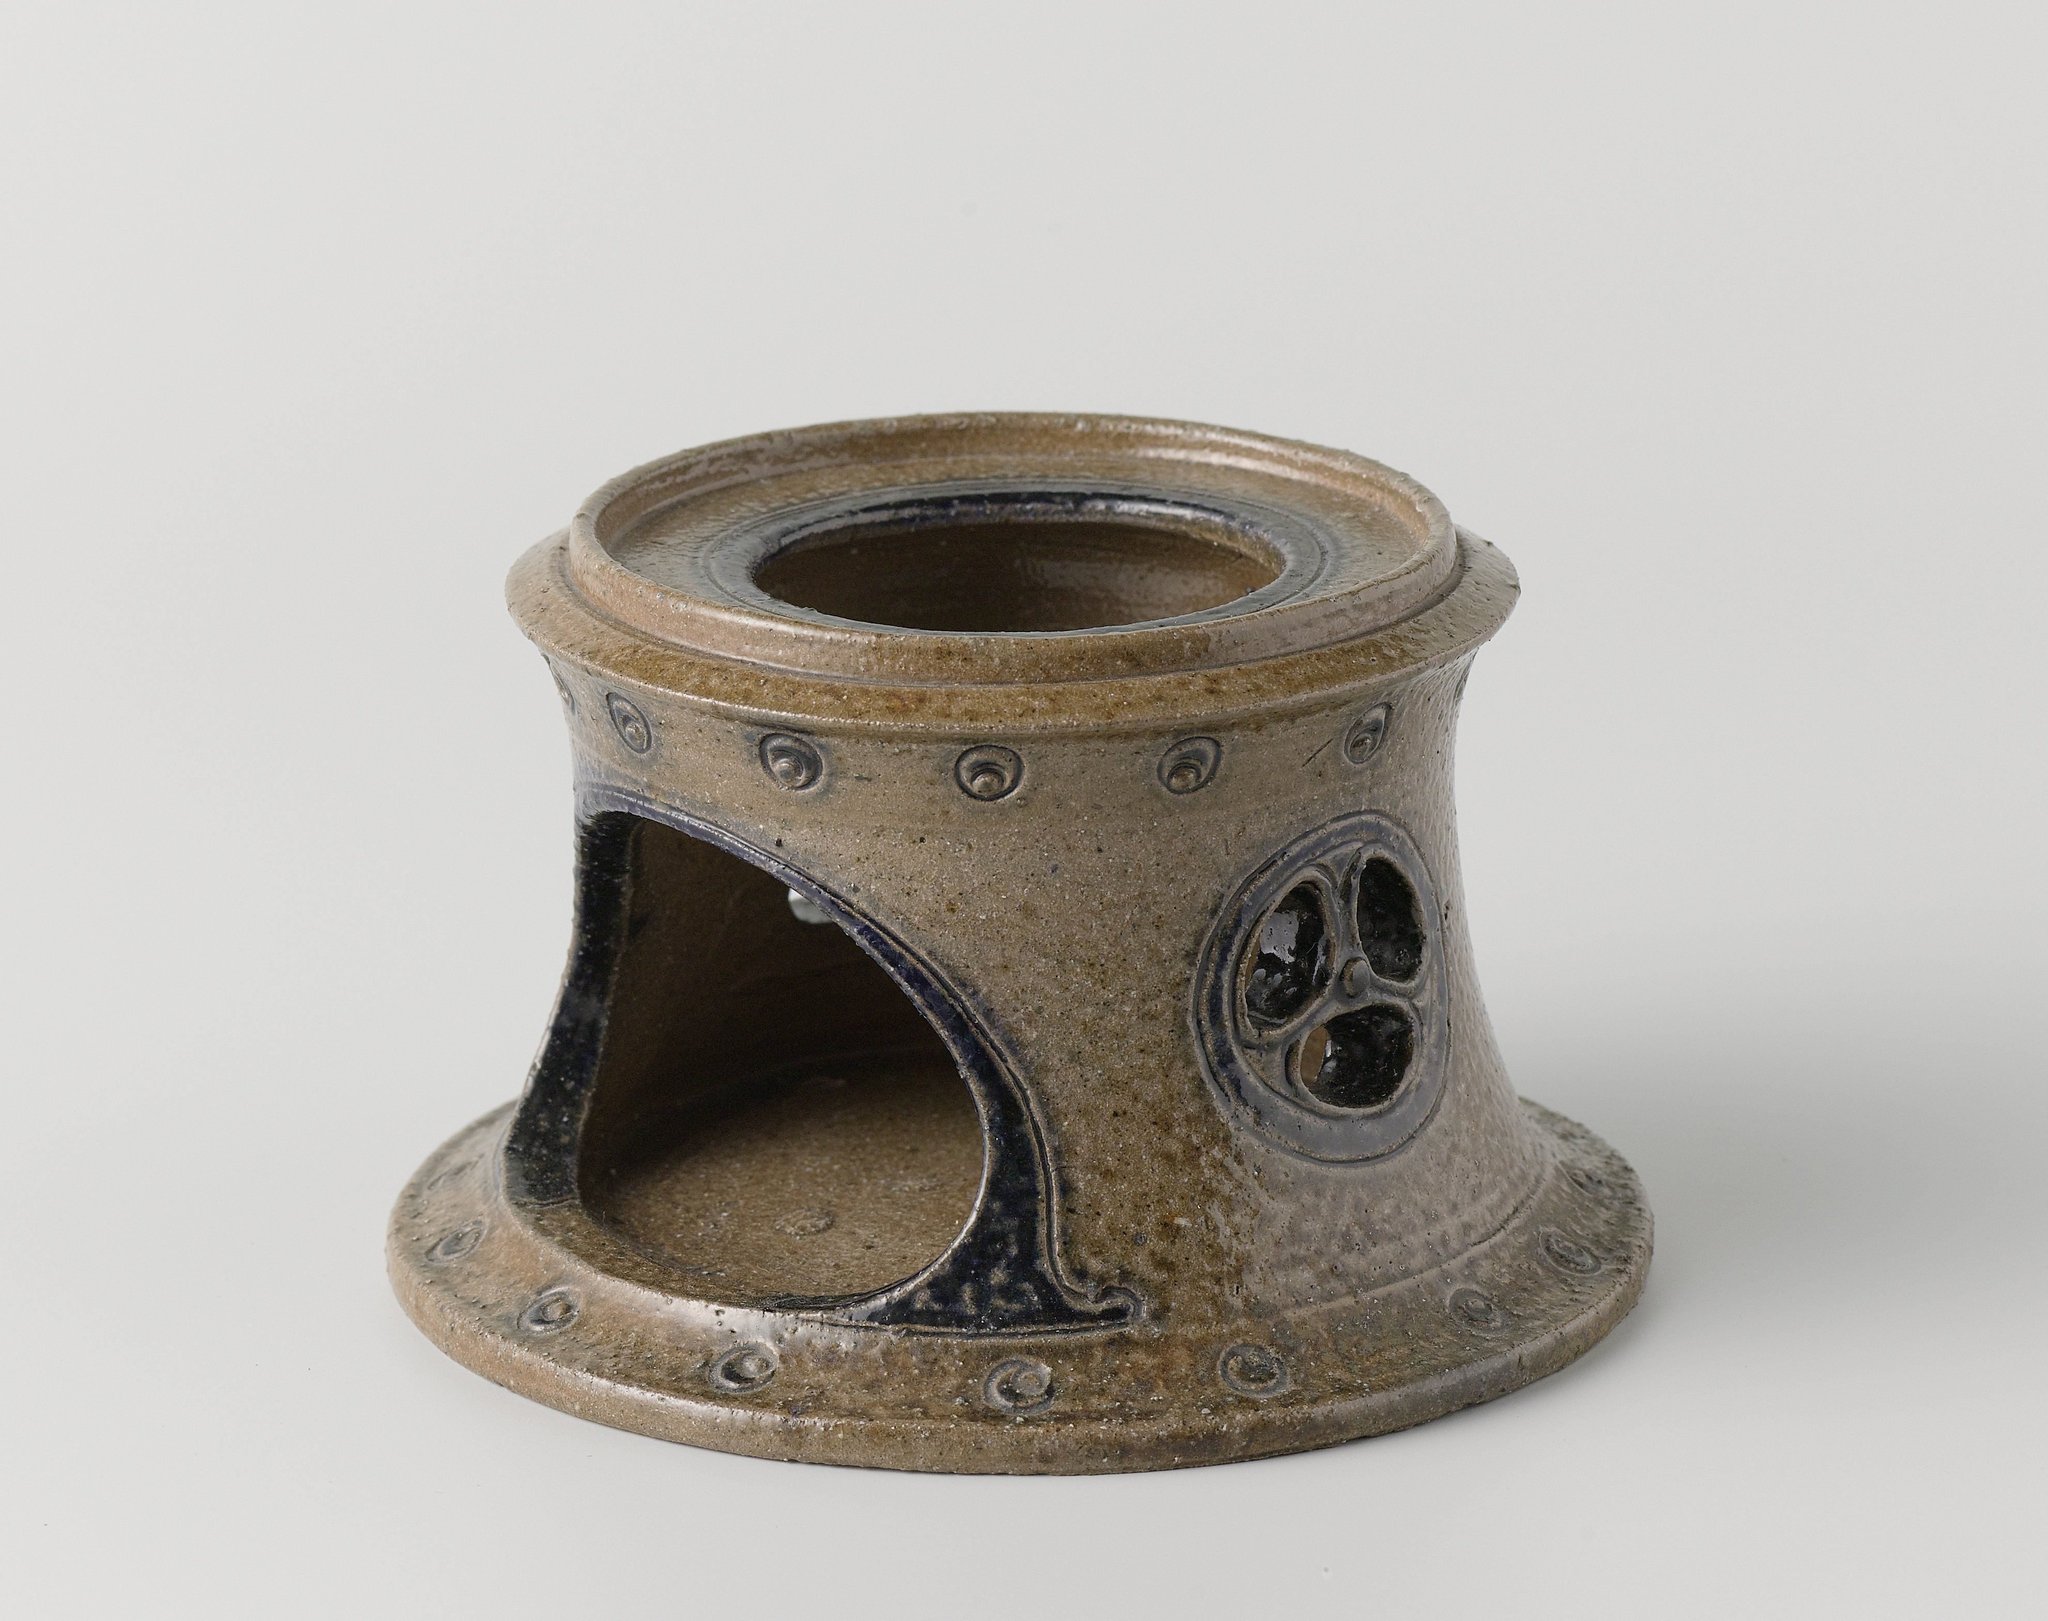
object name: vessel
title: Komfoor van steengoed met zoutglazuur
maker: joseph mendes da costa (1863-1939)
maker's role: print maker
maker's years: 1863-1939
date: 1901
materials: stoneware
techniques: firing, vitrification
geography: amsterdam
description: Komfoor van steengoed met zoutglazuur, onderdeel van een servies.